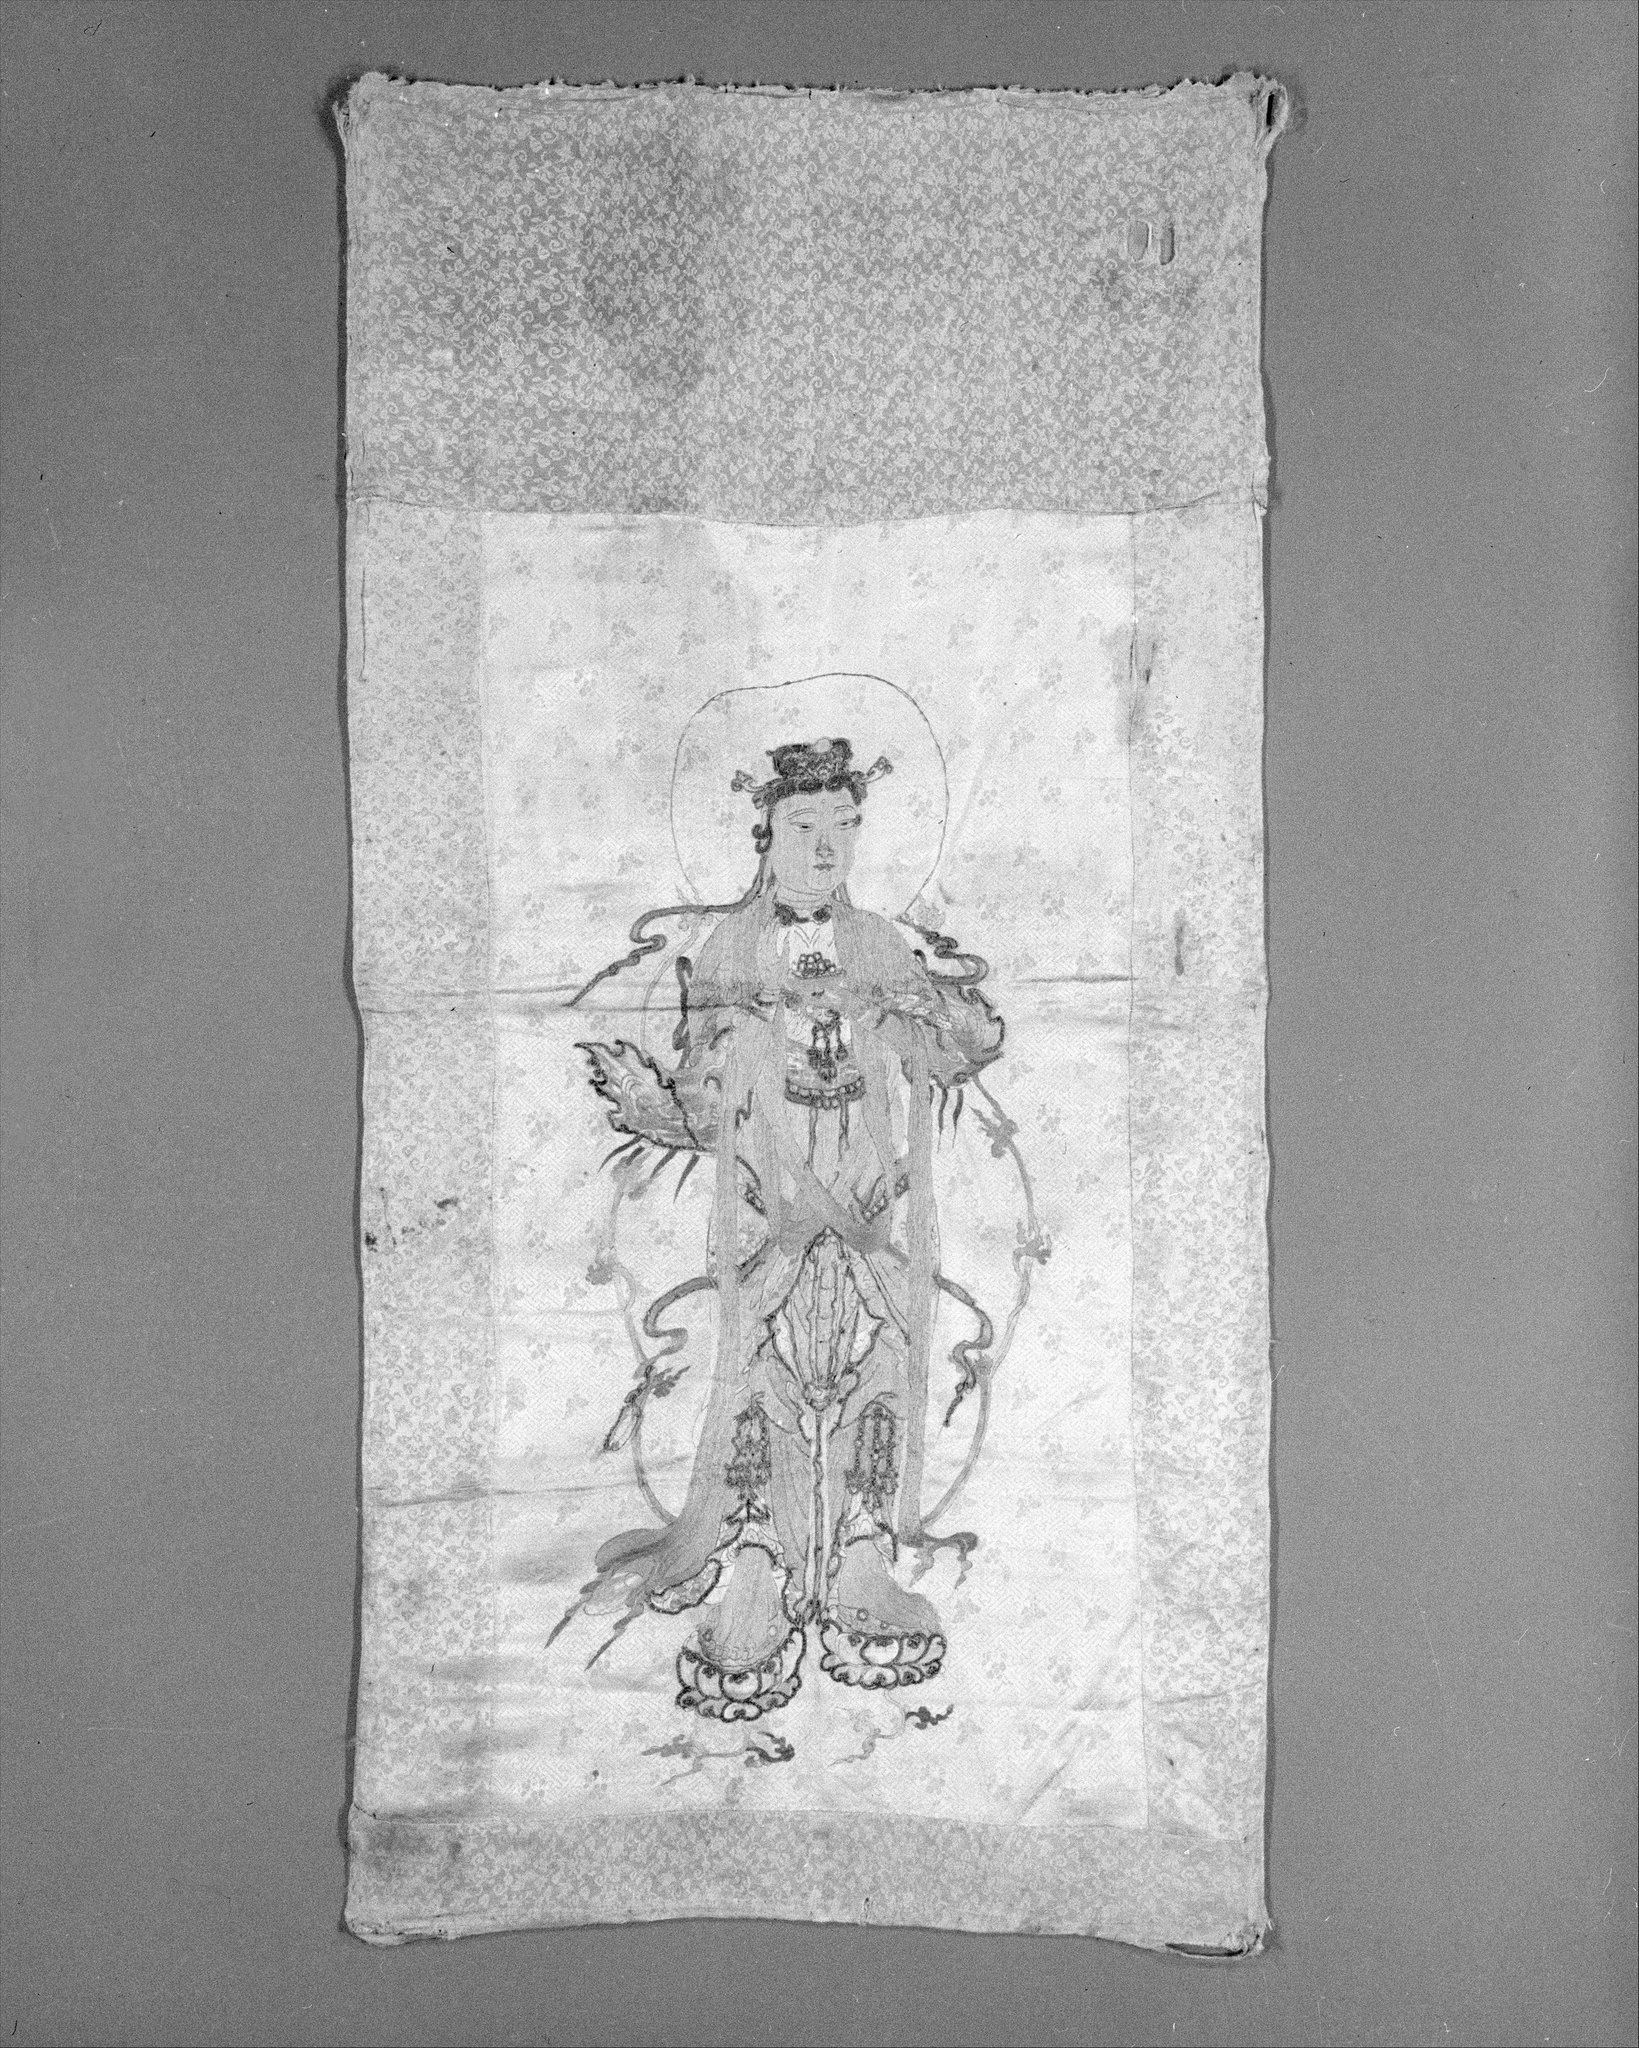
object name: panel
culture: chinese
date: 1567-1633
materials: cotton, metal thread, silk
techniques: backing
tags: bodhisattvas